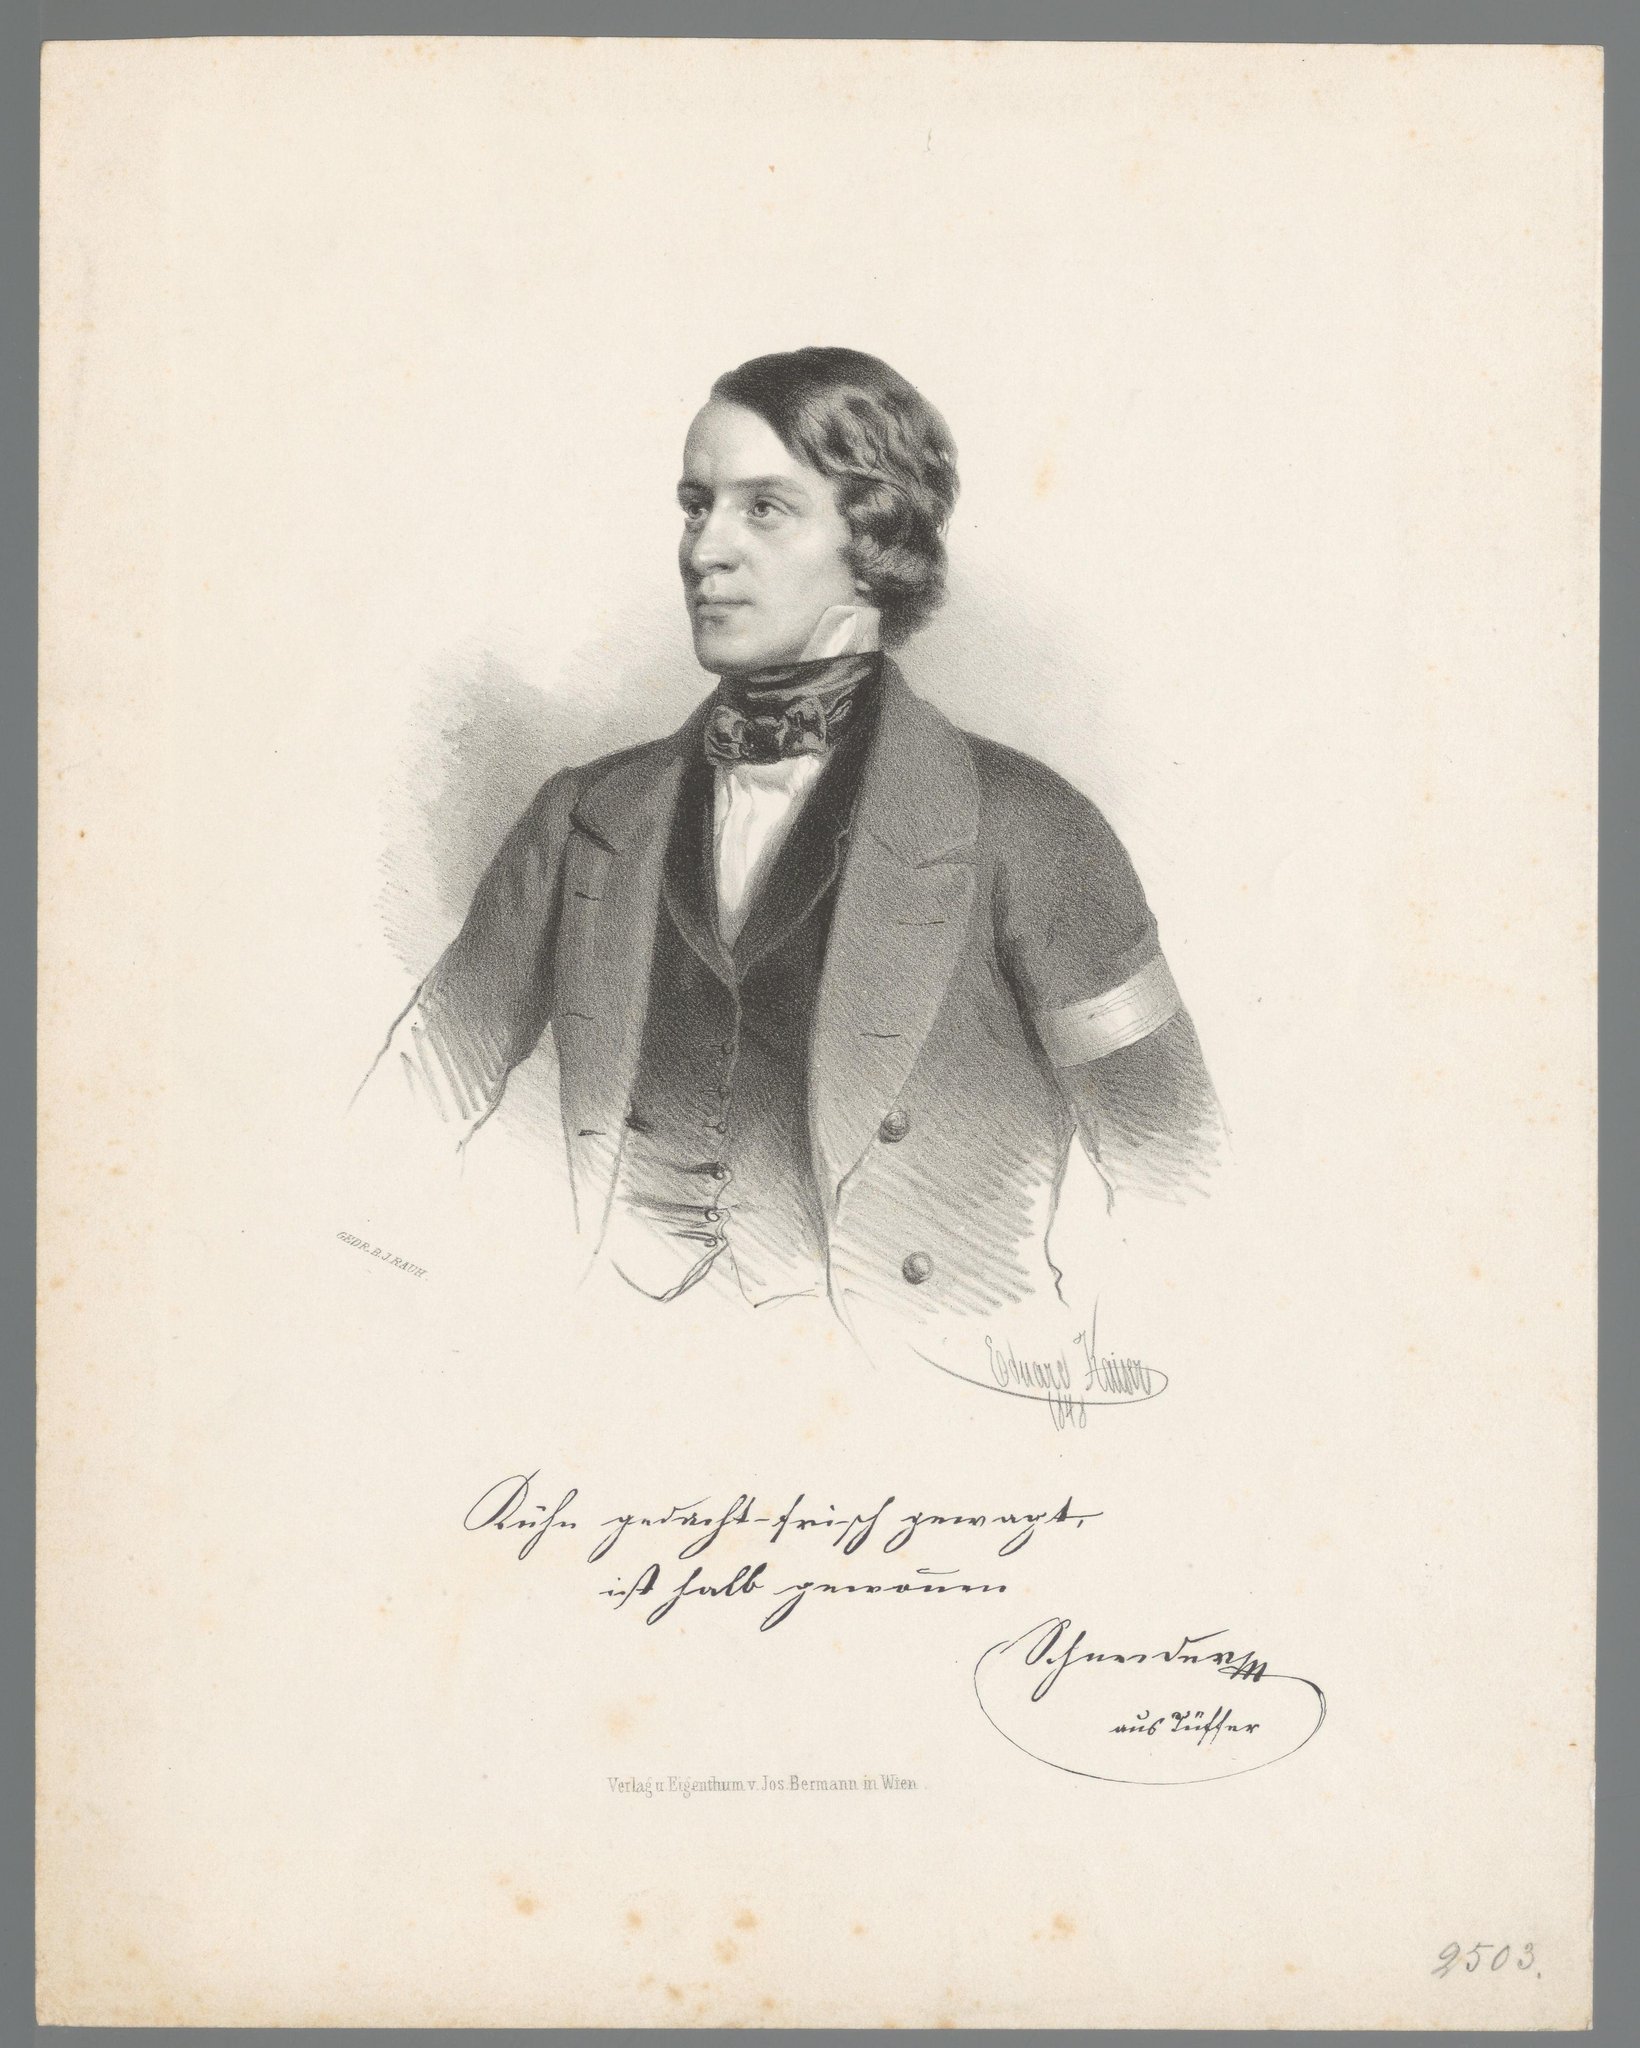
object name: print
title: Portret van een onbekende man, mogelijk Schneider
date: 1848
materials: paper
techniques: lithograph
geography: vienna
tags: adult man, historical persons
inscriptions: collector's mark: Lugt 2228